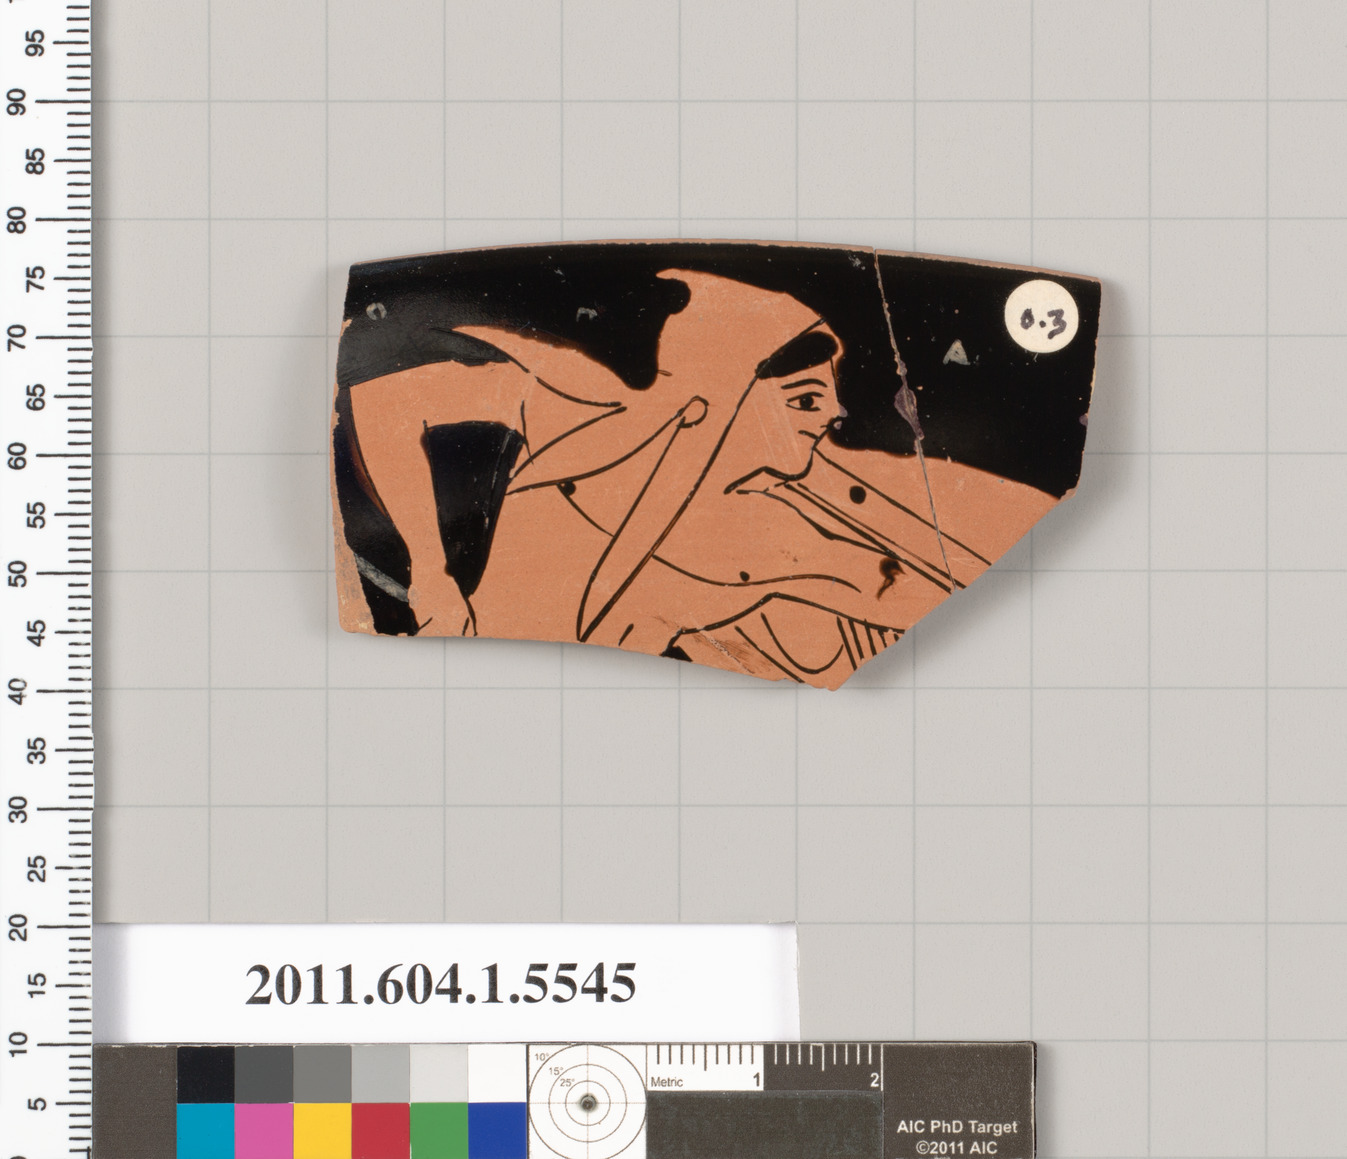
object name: kylix fragment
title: Terracotta rim fragment of a kylix (drinking cup)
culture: greek, attic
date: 500-490 BCE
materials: terracotta